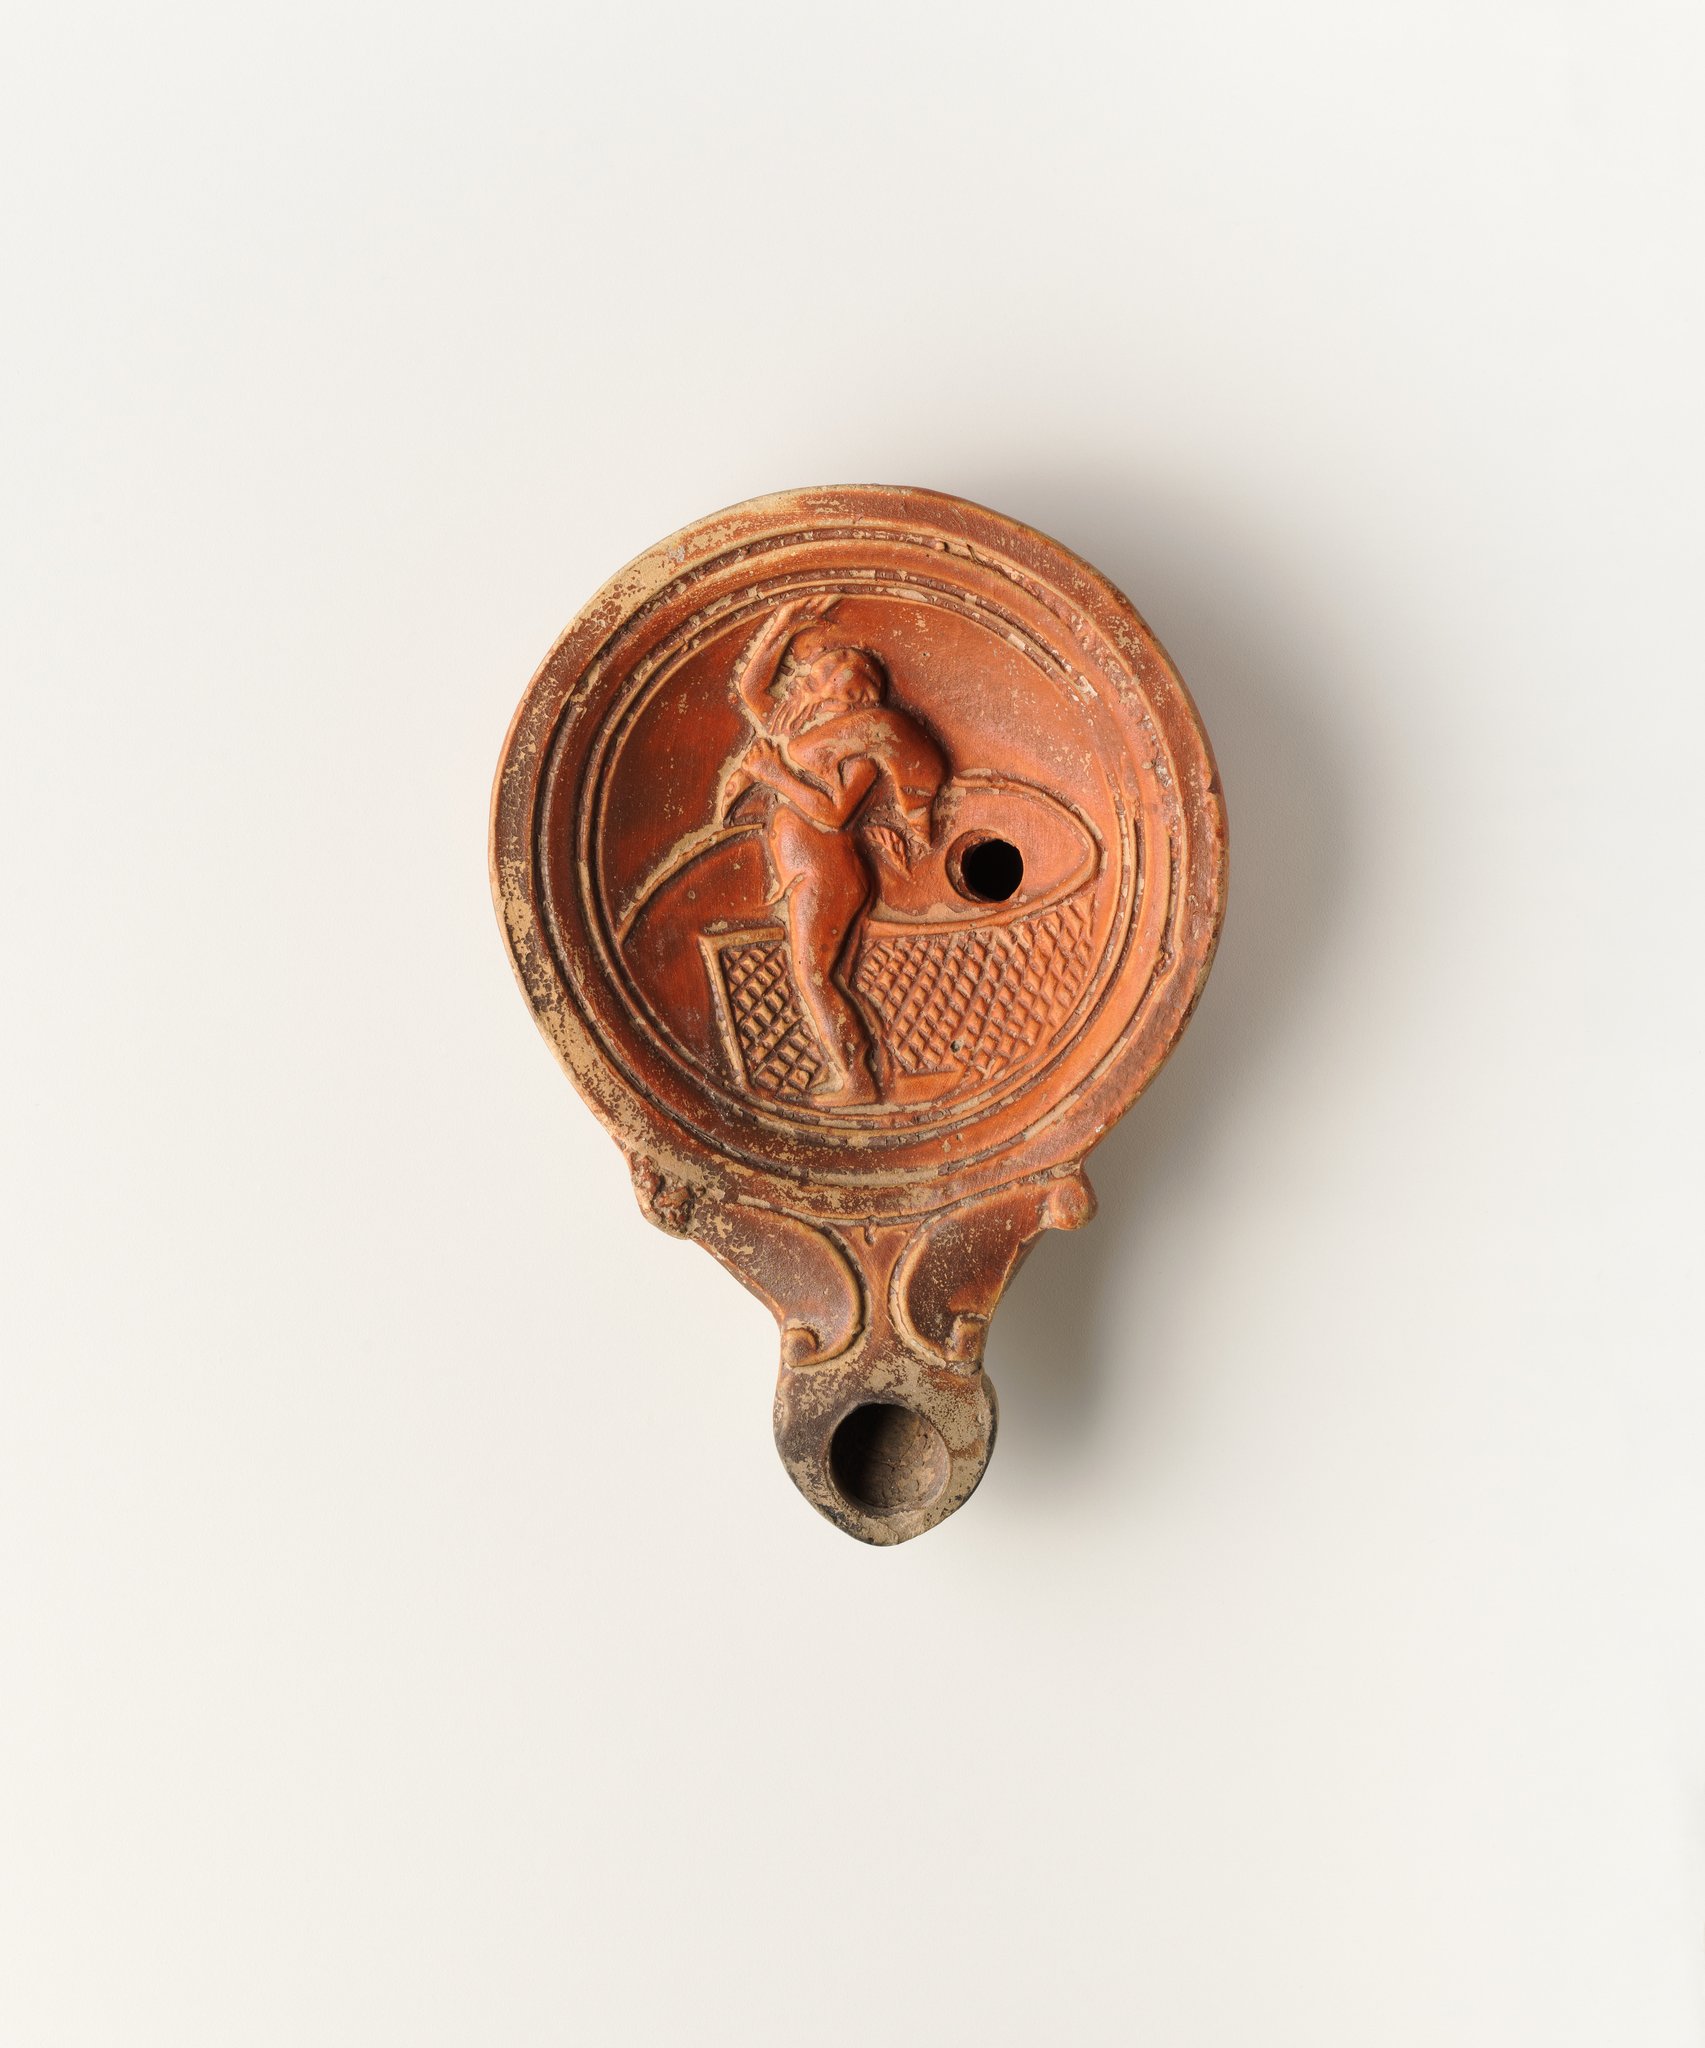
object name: lamp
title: Terracotta oil lamp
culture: roman, cypriot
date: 40-100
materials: terracotta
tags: silenus